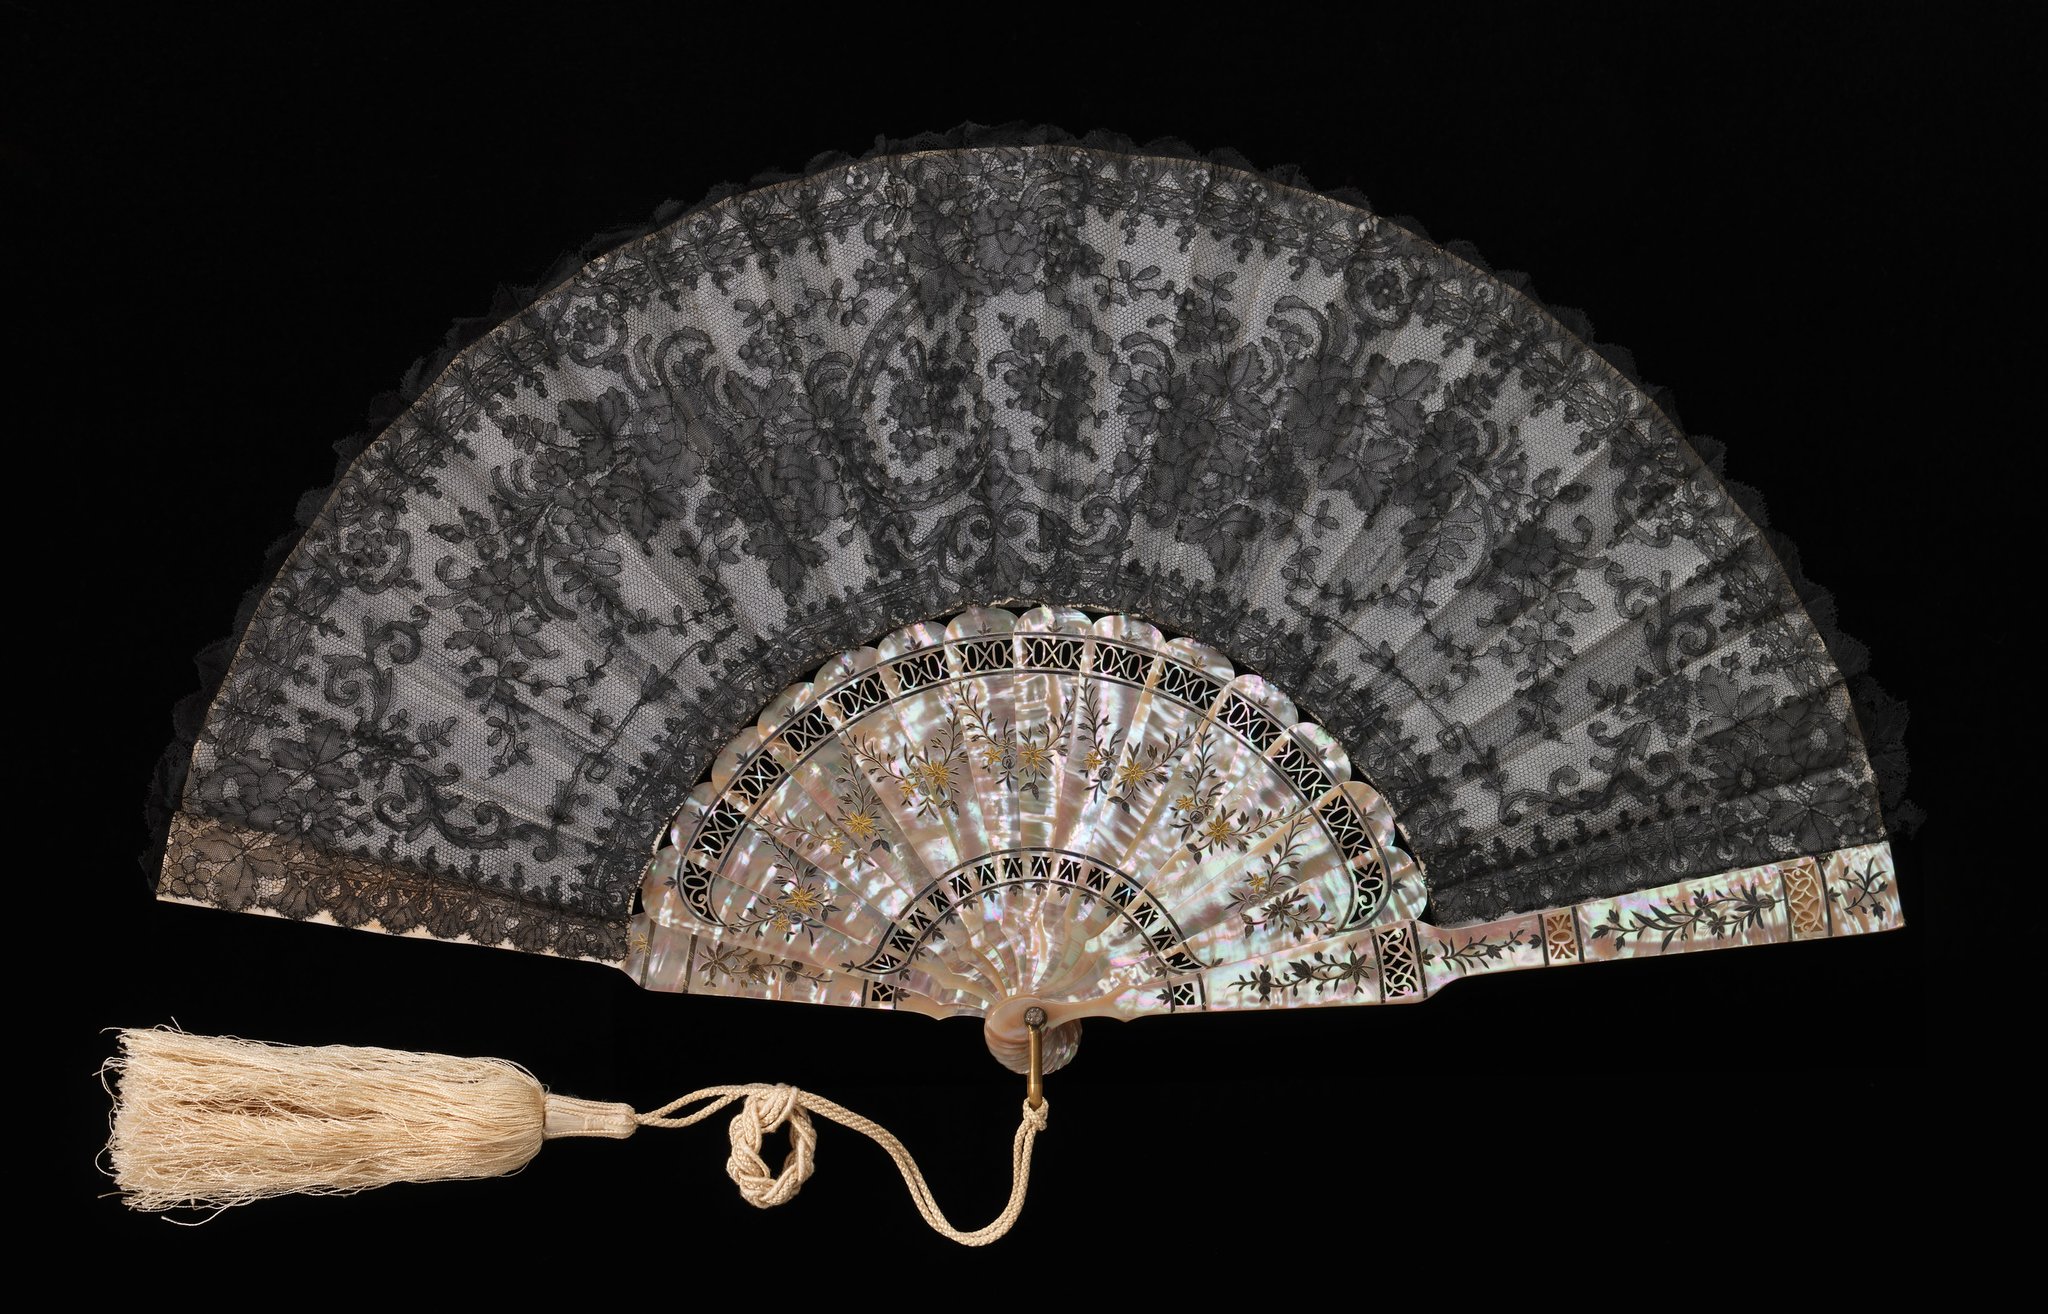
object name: fan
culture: french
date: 1870-1879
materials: glass, ivory, metal, mother of pearl, silk